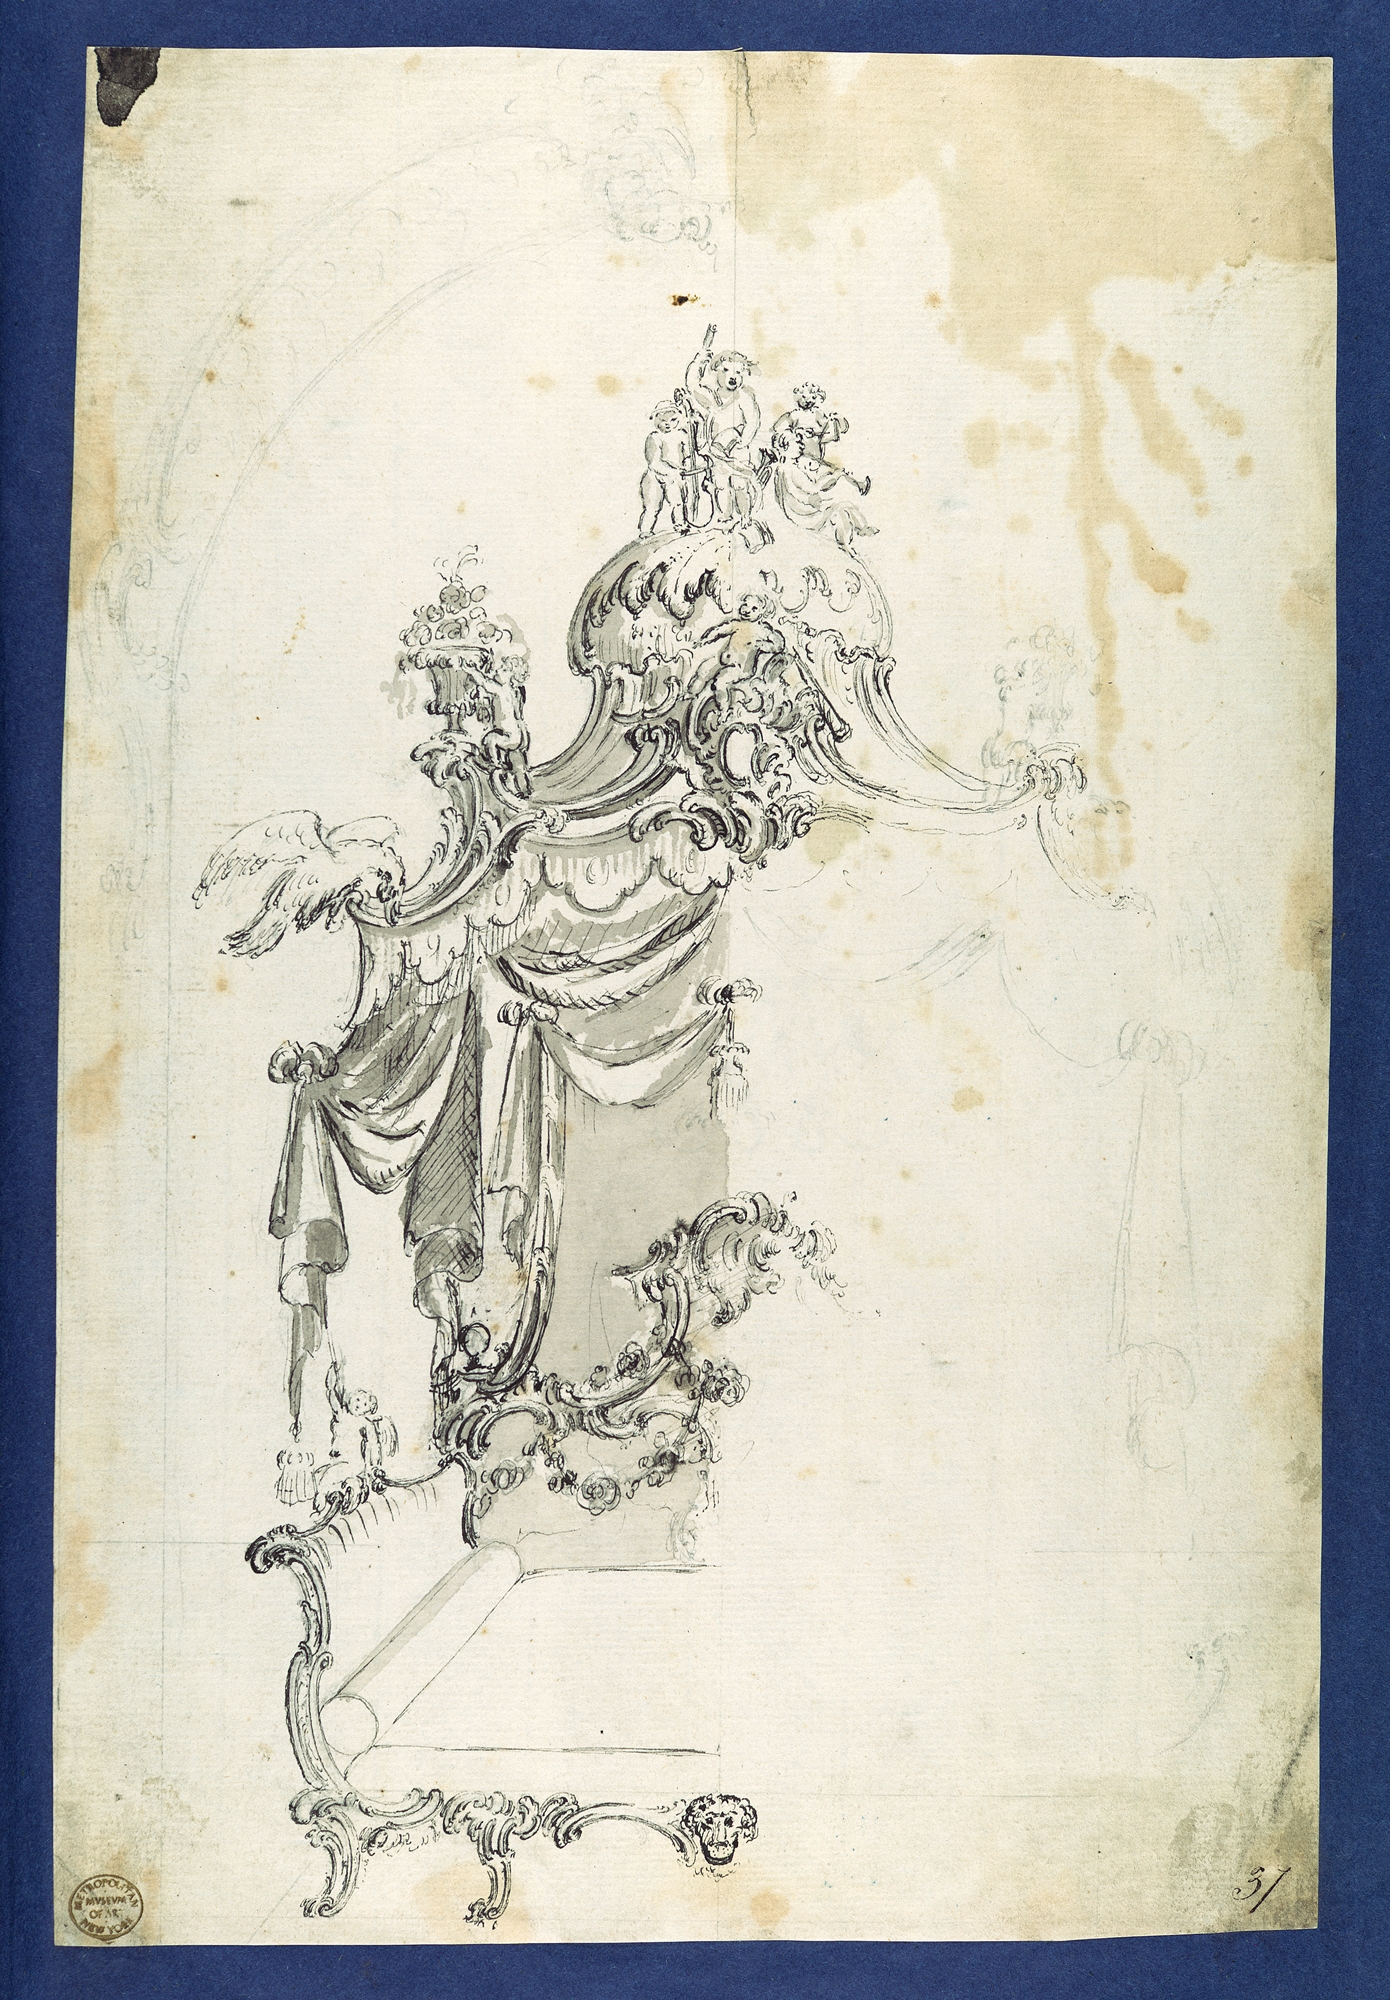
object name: drawing ornament architecture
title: Unfinished Design for a Bed, in Chippendale Drawings, Vol. I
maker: thomas chippendale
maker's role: artist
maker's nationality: british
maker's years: 1718-1779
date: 1753-1762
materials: ink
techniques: wash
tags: beds